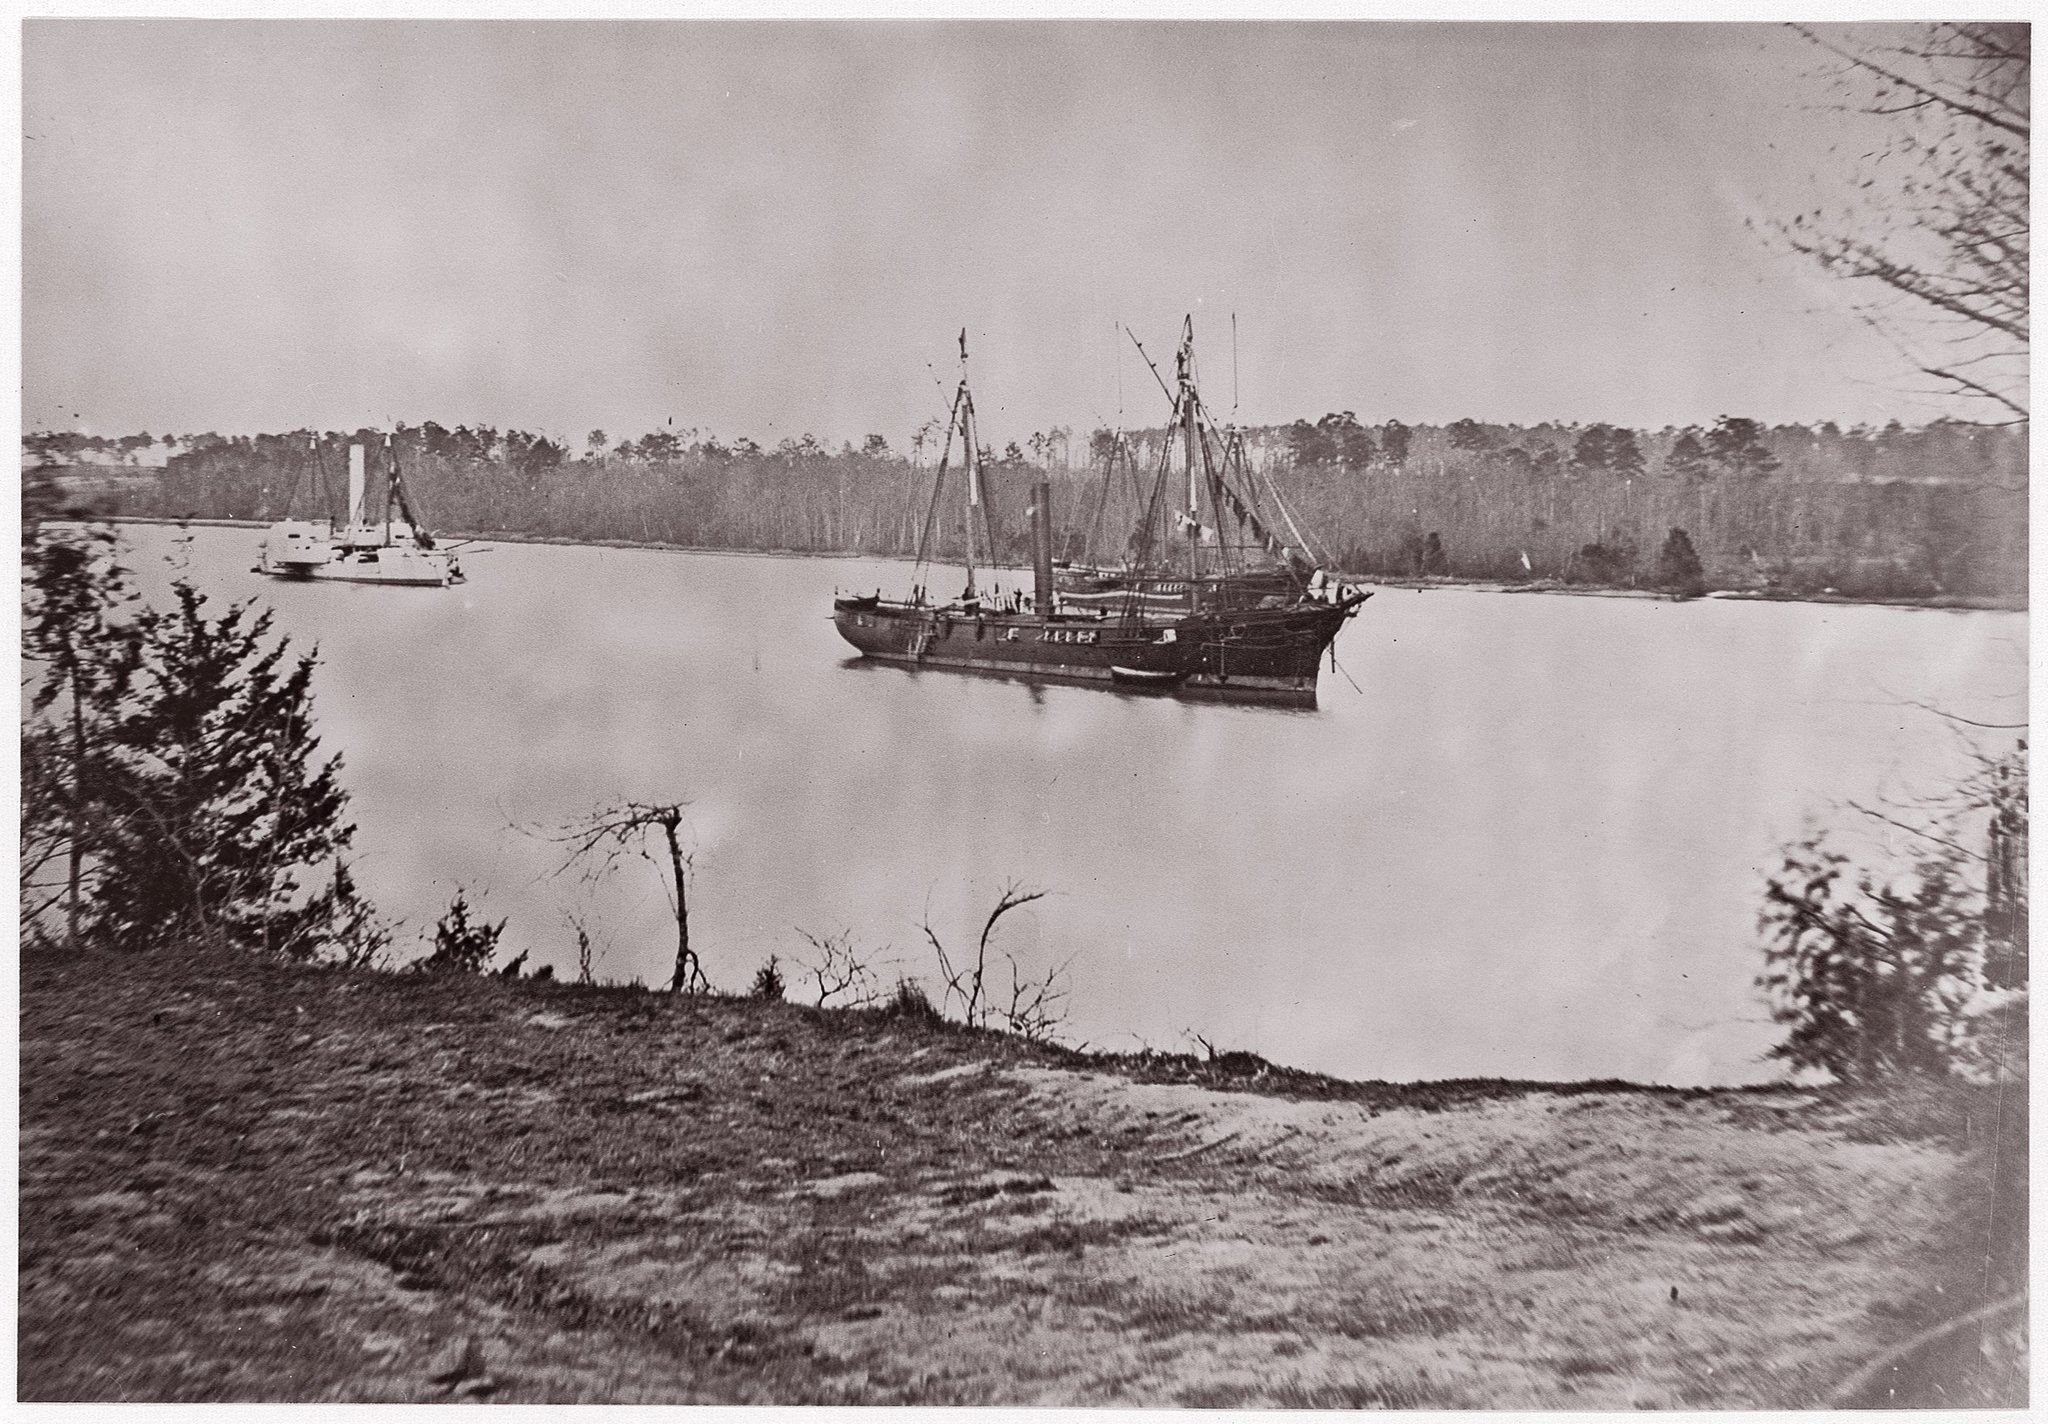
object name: photograph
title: [U.S. Gunboat "Mendota" and Other Ships on James River, Virginia]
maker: Anonymous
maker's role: artist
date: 1864-1865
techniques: albumen silver print, glass negative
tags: american civil war,rivers,ships